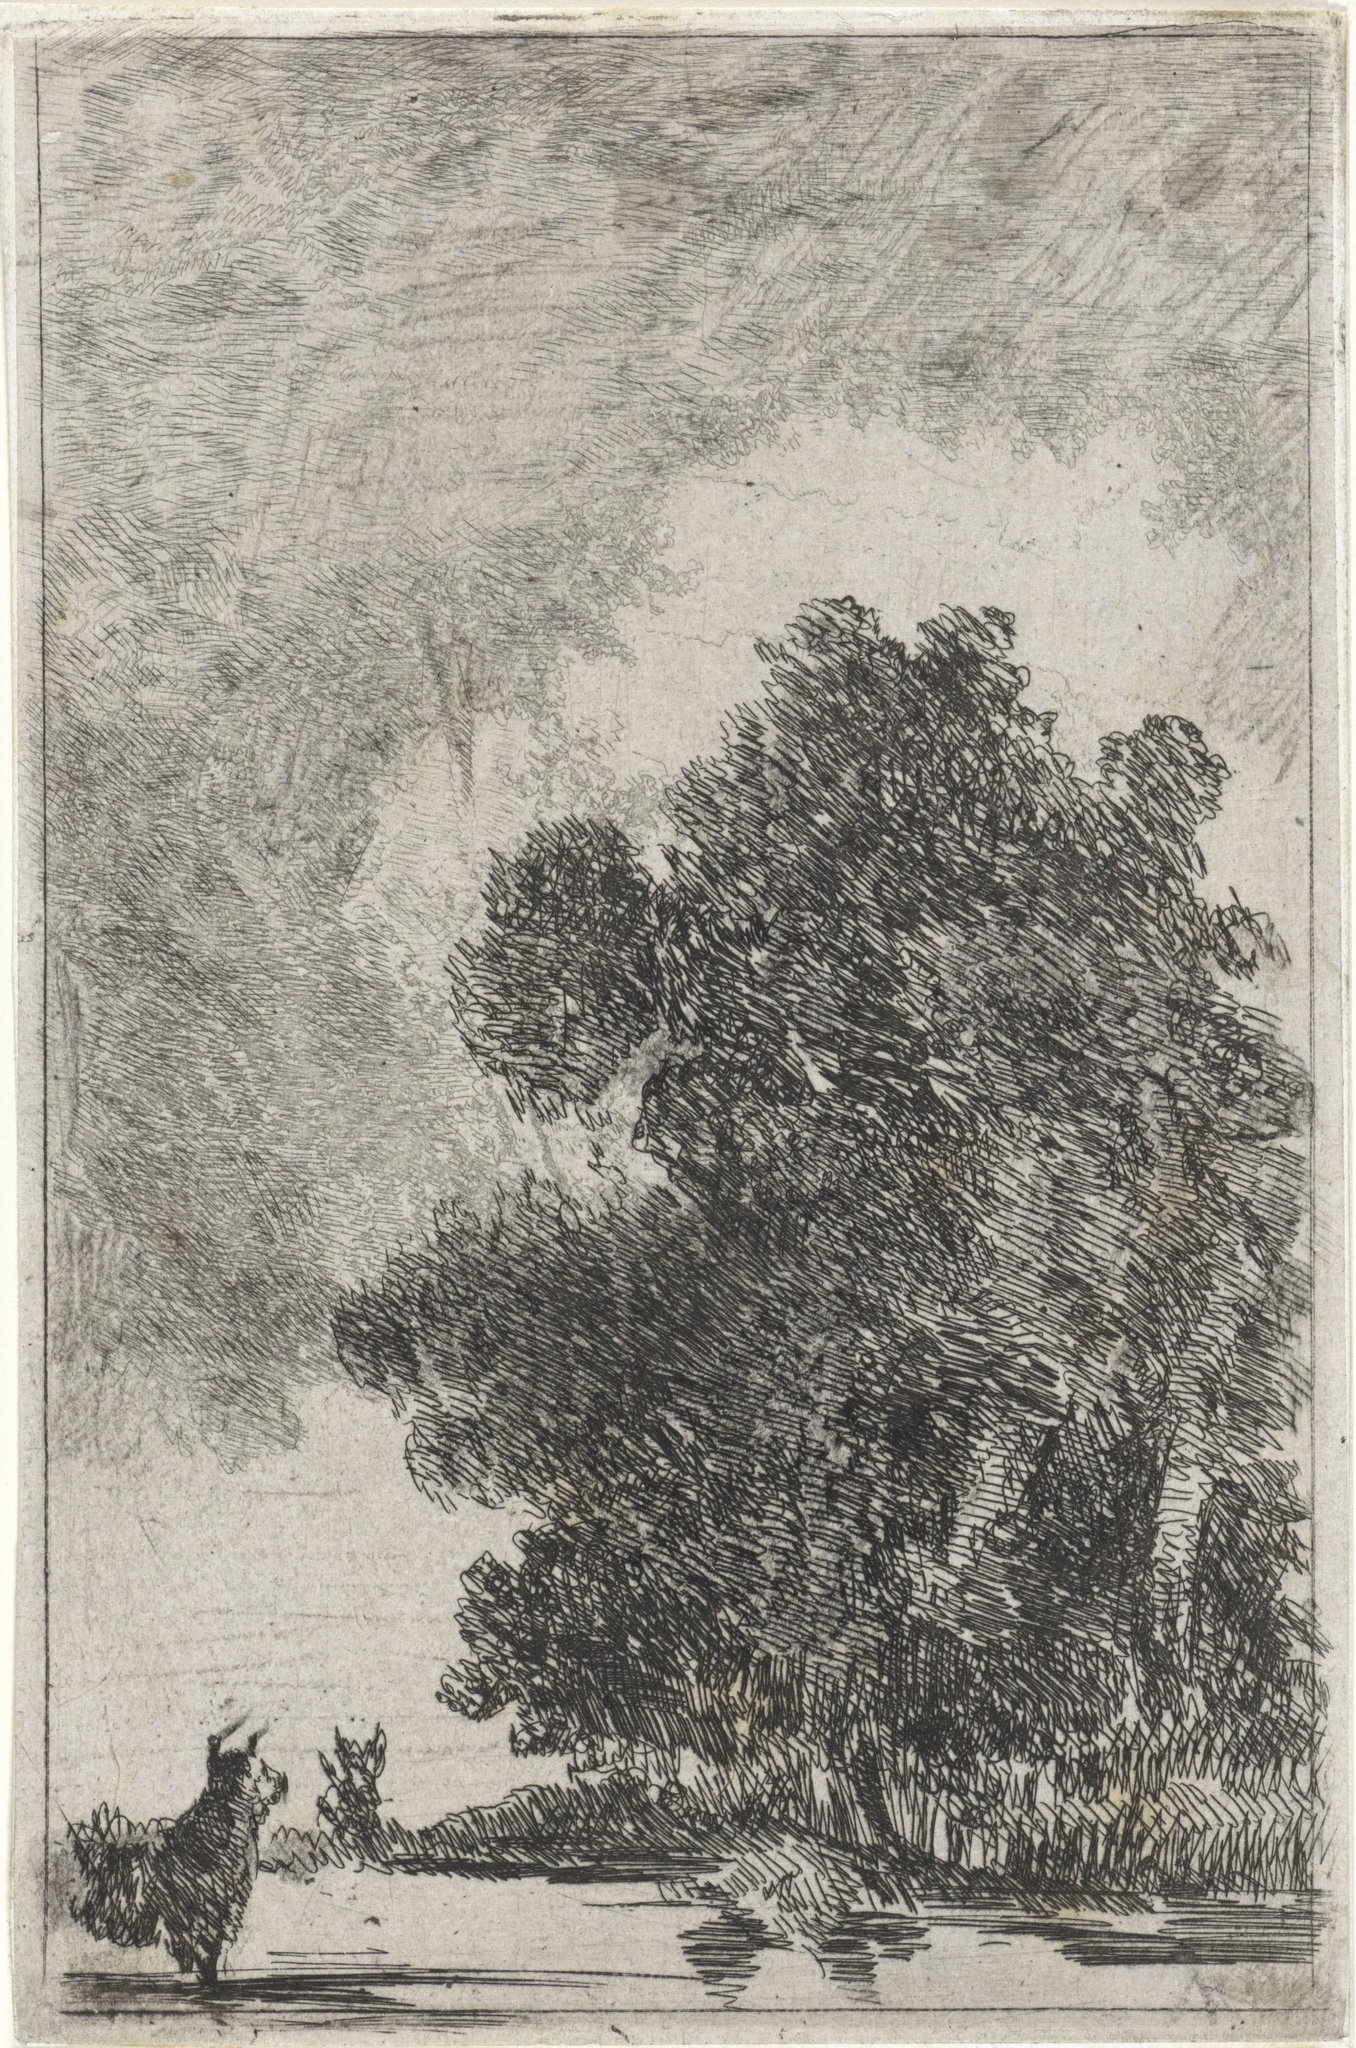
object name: print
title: Landschap met een koe bij het water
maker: arnoud schaepkens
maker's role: print maker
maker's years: 1816-1904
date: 1831-1904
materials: paper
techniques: etching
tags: cow, landscapes with waters, waterscapes, seascapes (in the temperate zone)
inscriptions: collector's mark: Lugt 2228